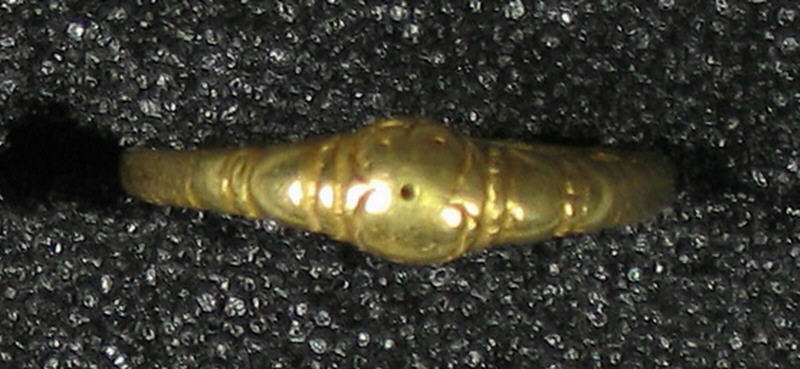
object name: ring, divided pointed arc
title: Ring with Divided, Pointed Arc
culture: indonesian, central java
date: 701-1200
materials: gold